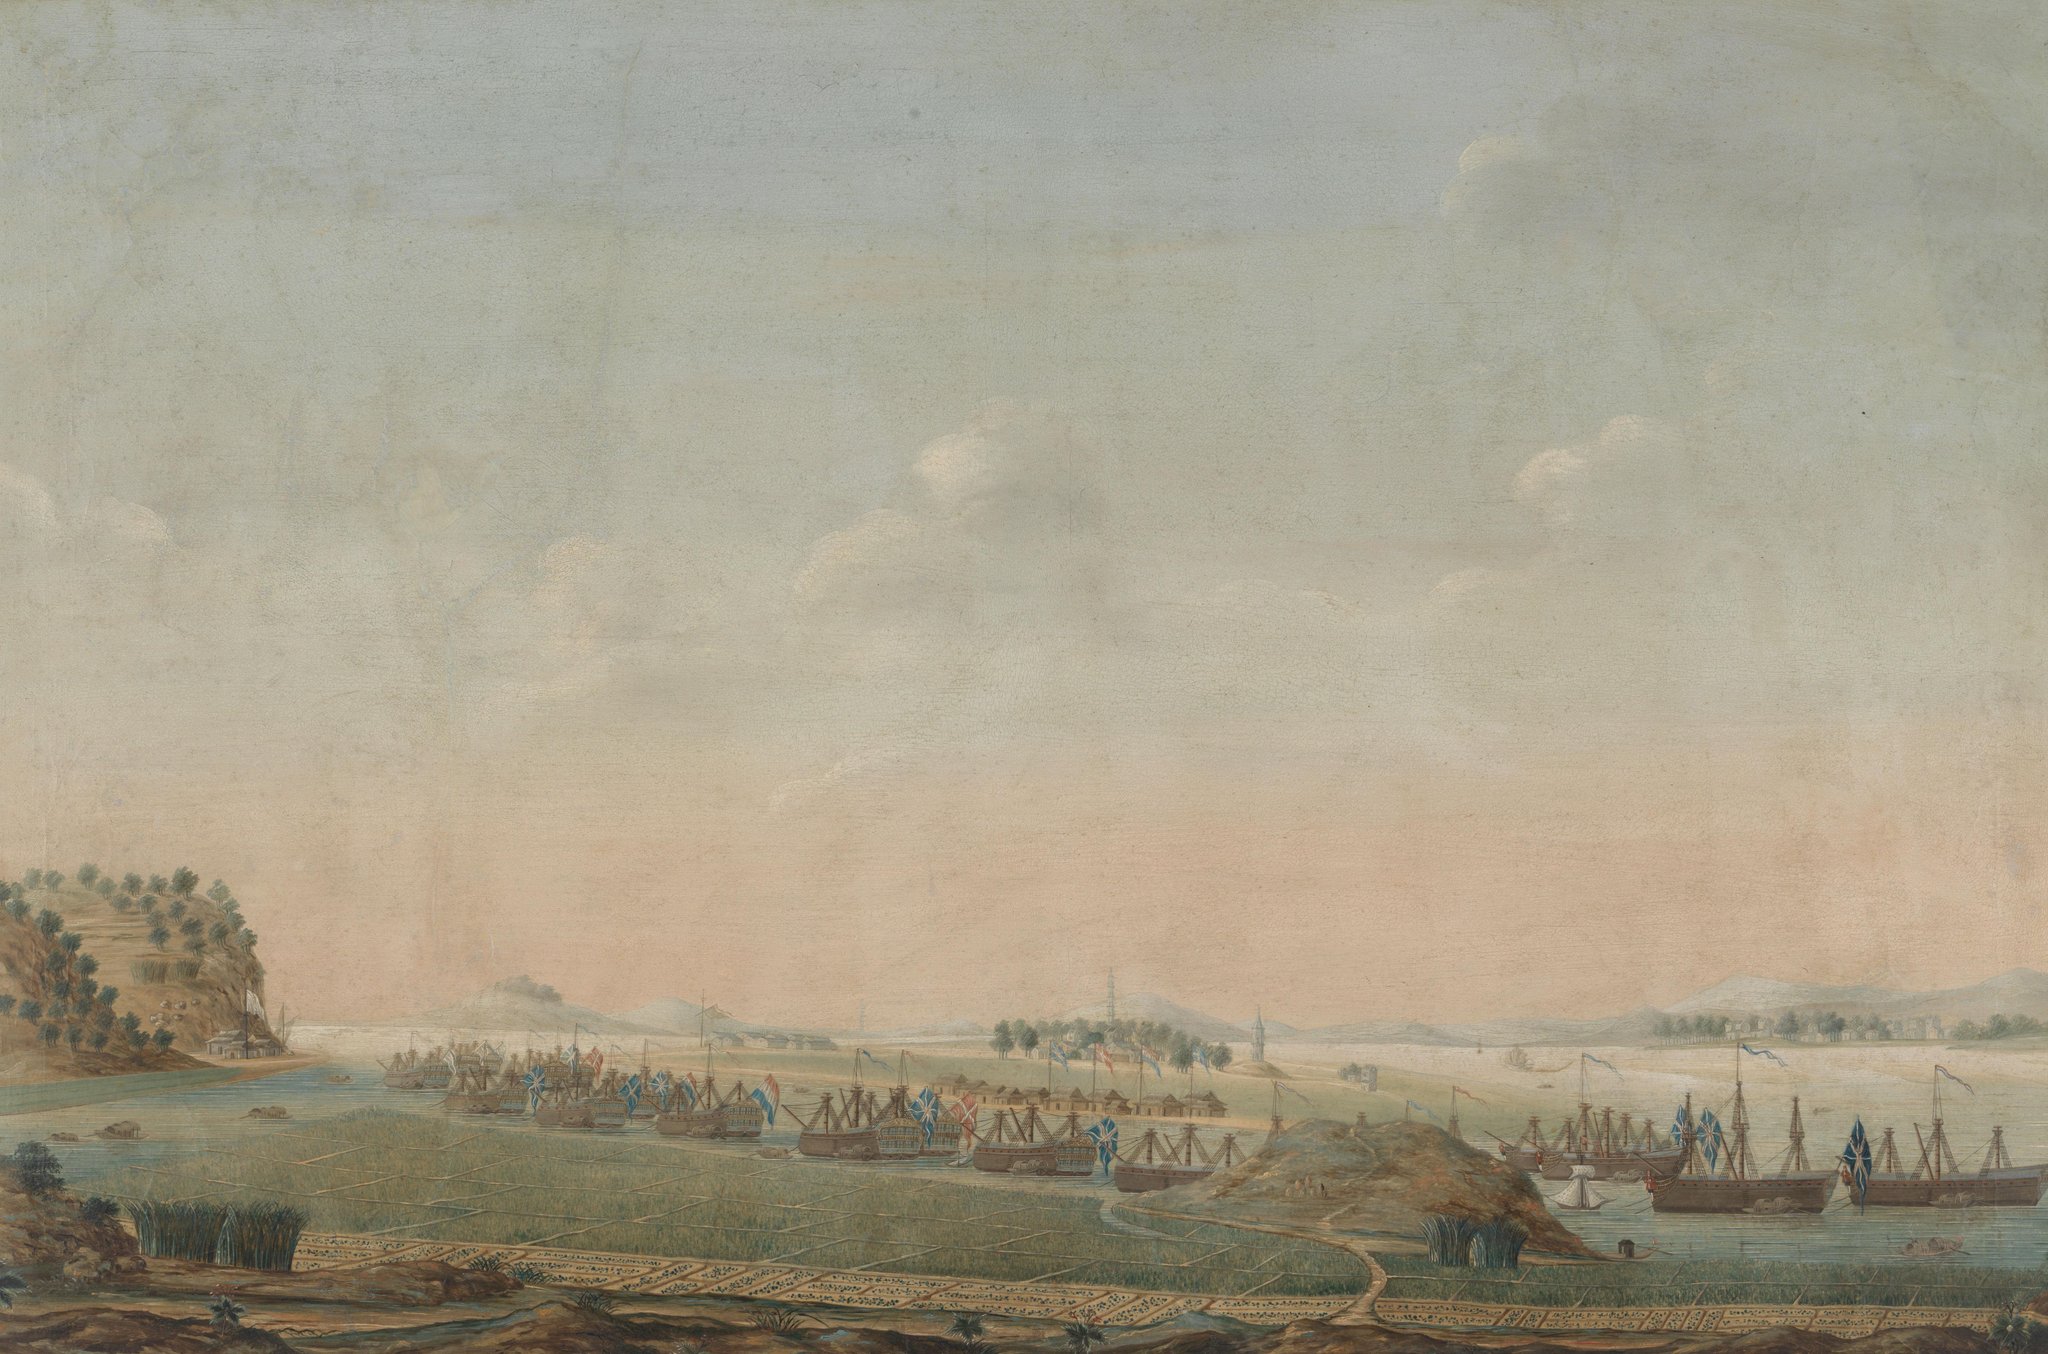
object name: painting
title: Whampoa Anchorage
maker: Anonymous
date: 1773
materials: canvas, oil, paint, paper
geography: china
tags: island, ship in the roads, roadstead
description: Various European trade organizations had branches in the port of Canton. Because there was so much construction, the paintings can be easily dated. This is the situation in 1773. The ships are moored in the estuary of the Pearl River (Whampoa); the merchants’ offices were located upriver. During the off-season the European traders stayed in Macao, which was also in the mouth of the Pearl River.